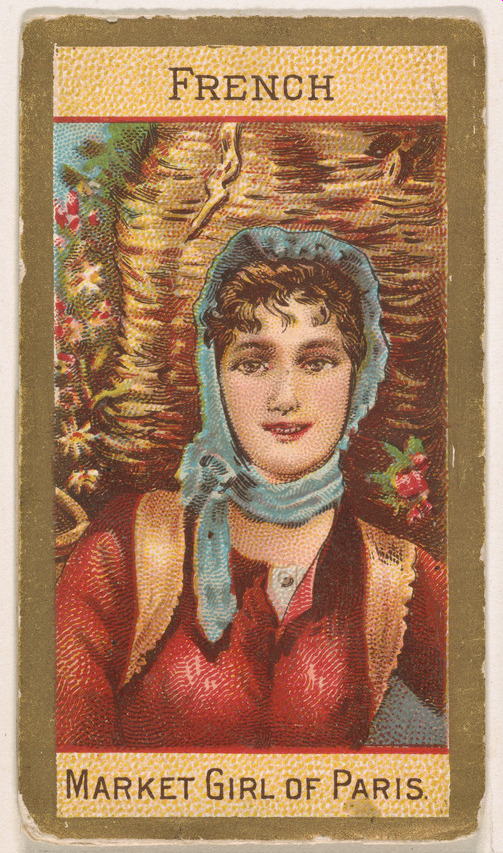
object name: print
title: French, Market Girl of Paris, from Types of Nationalities (N240) issued by Kinney Bros.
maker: kinney brothers tobacco company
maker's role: publisher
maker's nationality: american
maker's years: 1869-2011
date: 1890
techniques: color lithograph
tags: women